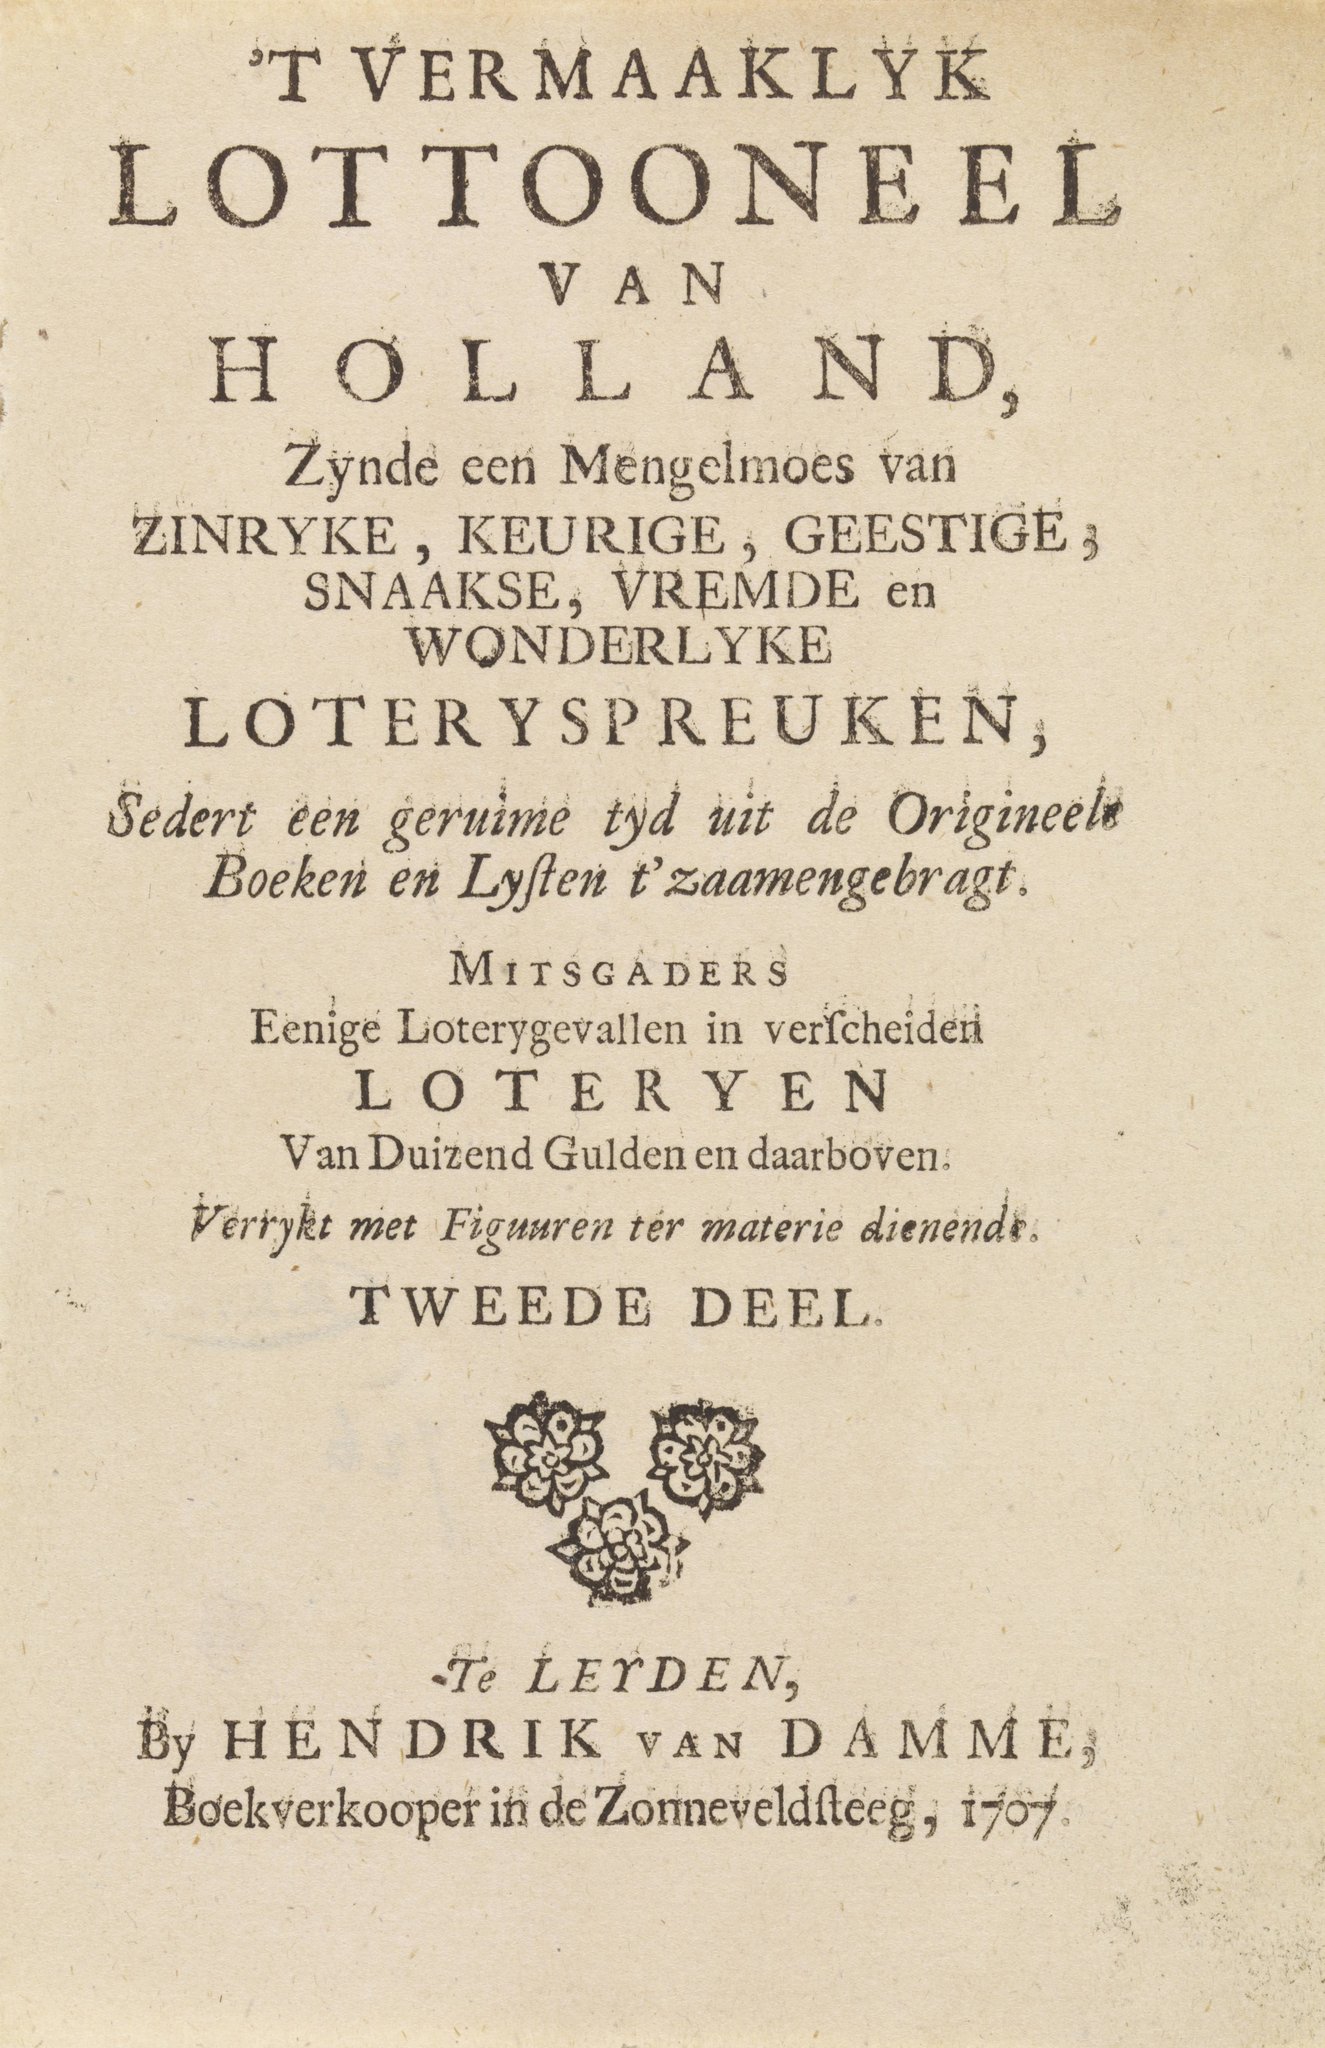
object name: text sheet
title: Titelpagina voor 'tVermakelijk lottooneel van Holland, 1707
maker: hendrik van damme (ii)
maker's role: publisher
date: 1707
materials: paper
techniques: letterpress printing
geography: leiden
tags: title-page, device (trade-mark of printer or publisher), flowers: rose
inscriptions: collector's mark: Lugt 2228, collector's mark: Lugt 2760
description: Titelpagina voor 'tVermakelijk lottooneel van Holland. Tweede deel. Leiden bij Hendrik van Damme, 1707.